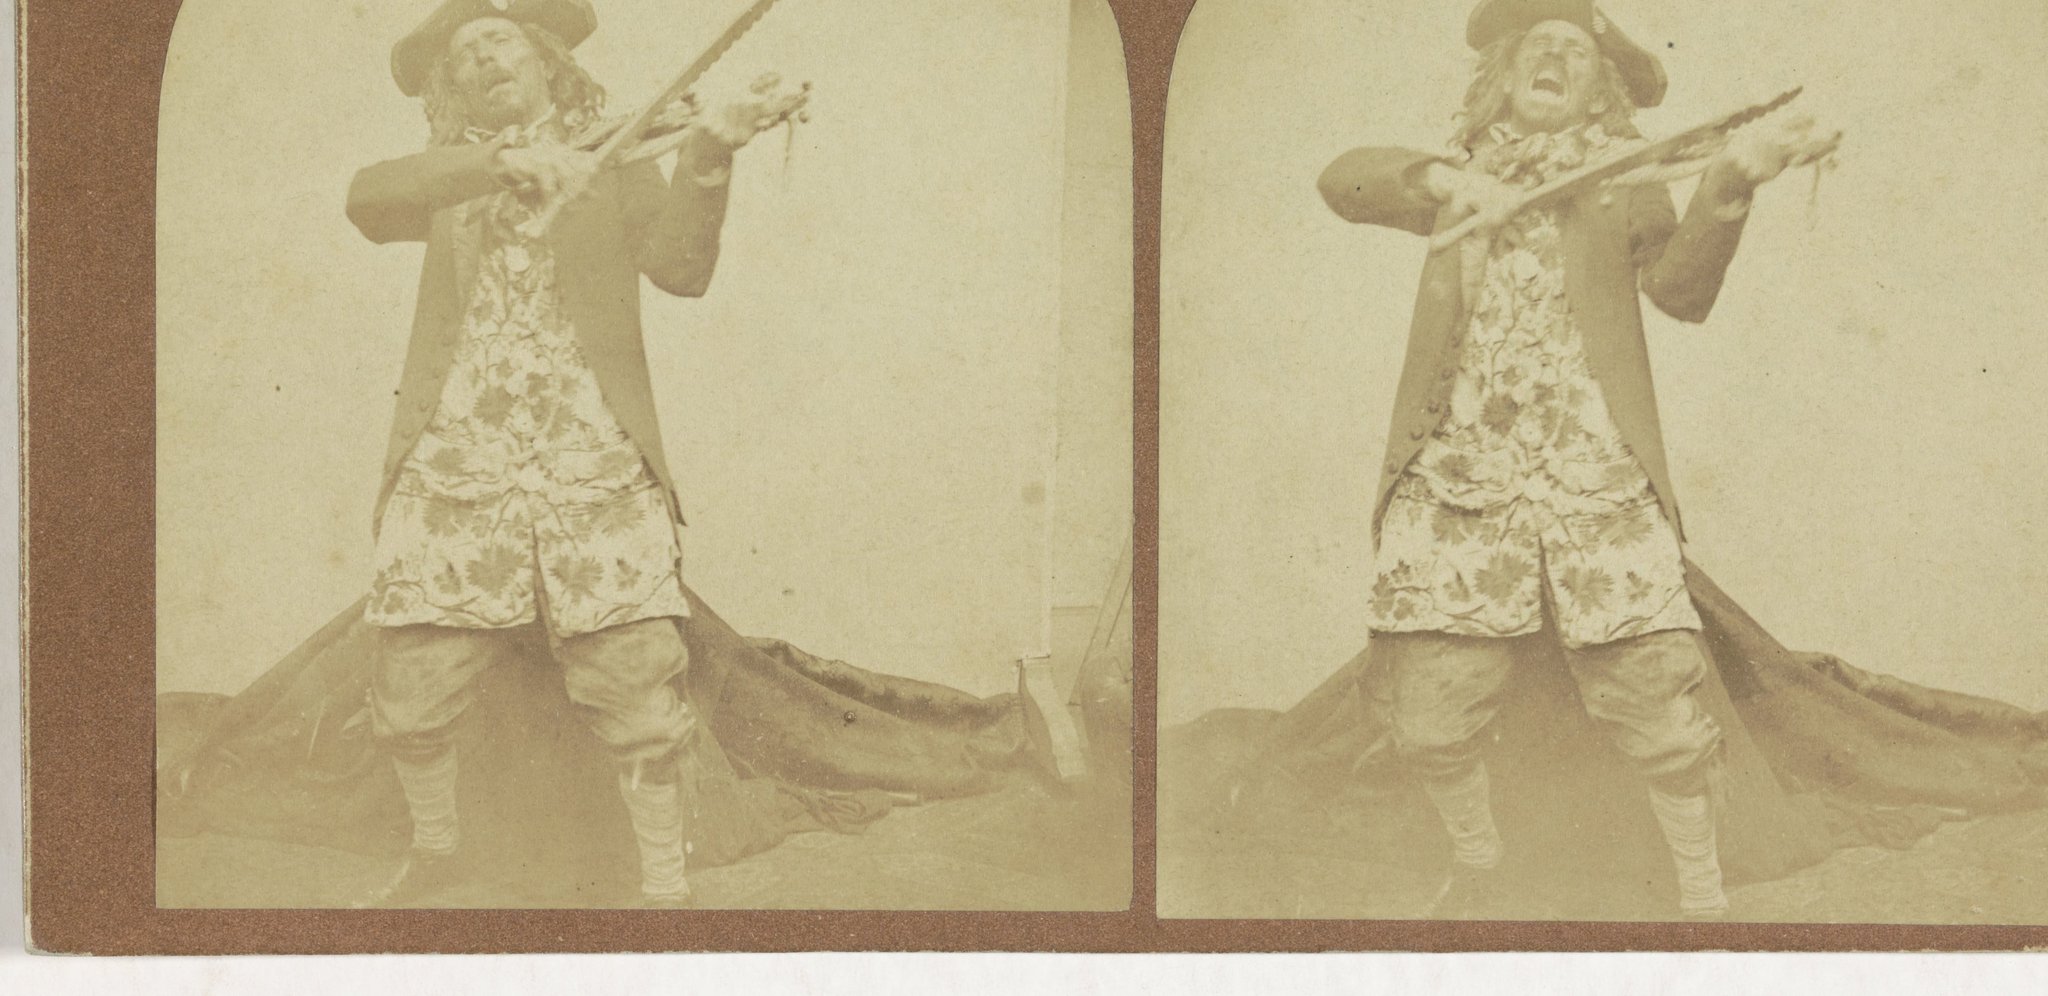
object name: stereograph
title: ÉPREUVE A MOUVEMENT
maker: Anonymous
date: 1855-1875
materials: cardboard, paper, photographic support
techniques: albumen print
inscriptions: inscription: ‘17’, check stamp: ‘Brevete F. T. S.G.D.C (?)’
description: Quasi-stereofoto van een man die viool speelt.